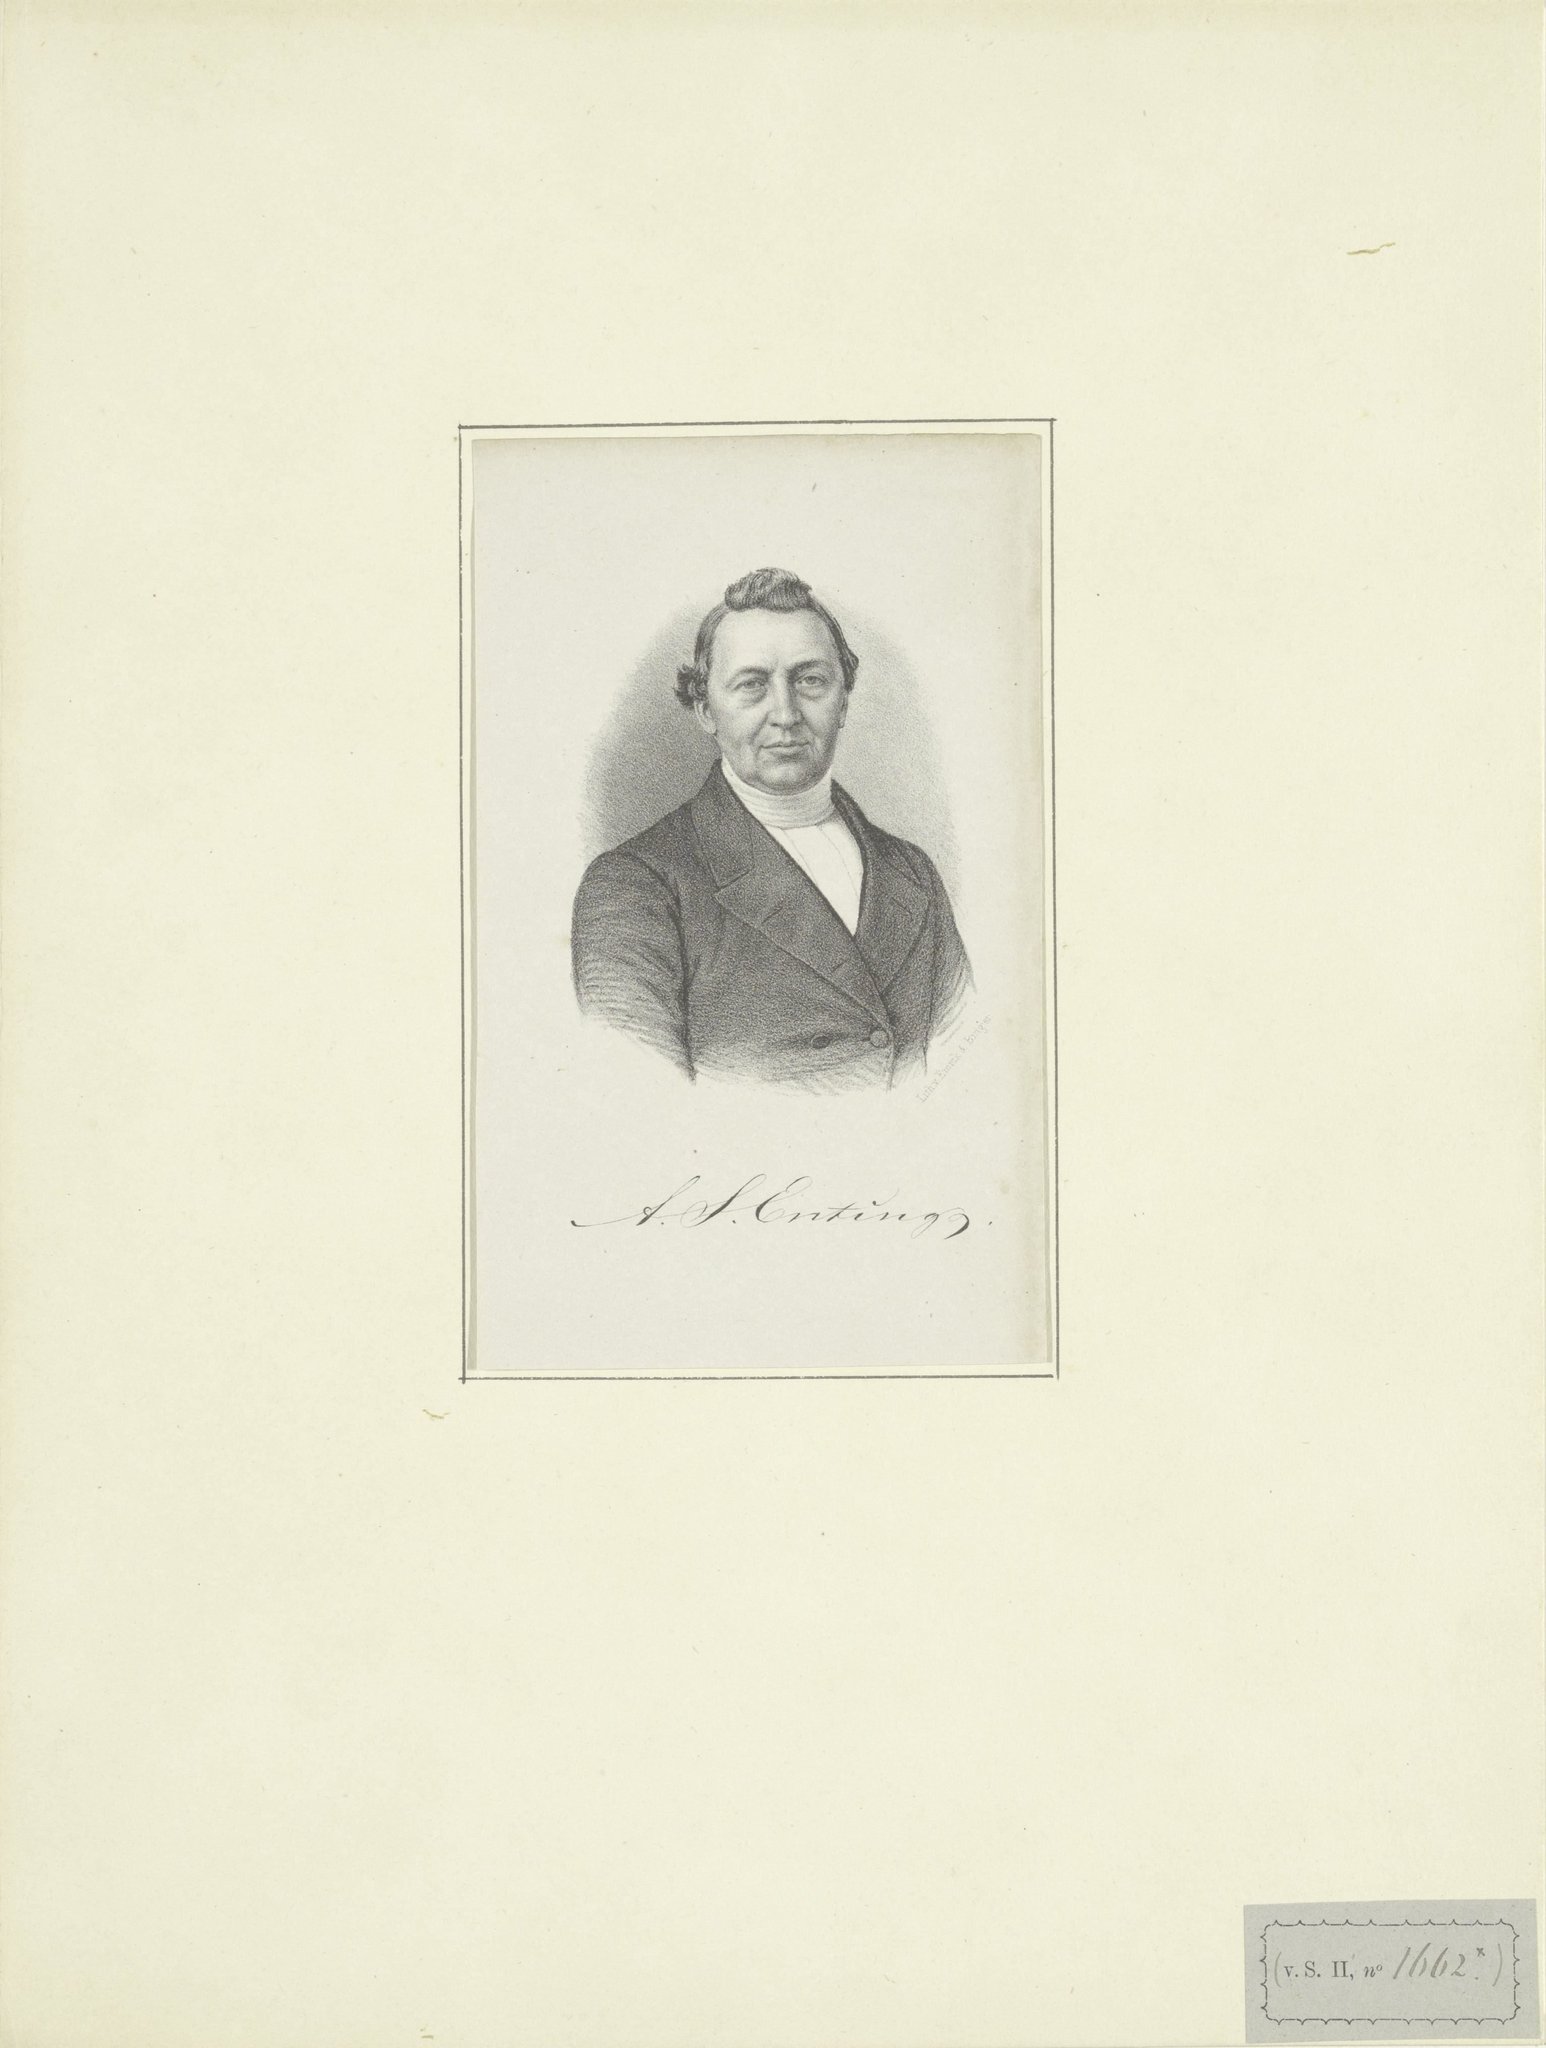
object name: print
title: Portret van A.S. Entingh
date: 1857-1909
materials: paper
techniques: lithograph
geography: haarlem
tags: historical persons (+ (full) bust portrait)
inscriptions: collector's mark: Lugt 2228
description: De geportretteerde draagt een overhemd met een hoge witte boord en een jas. Onder het portret zijn signatuur.